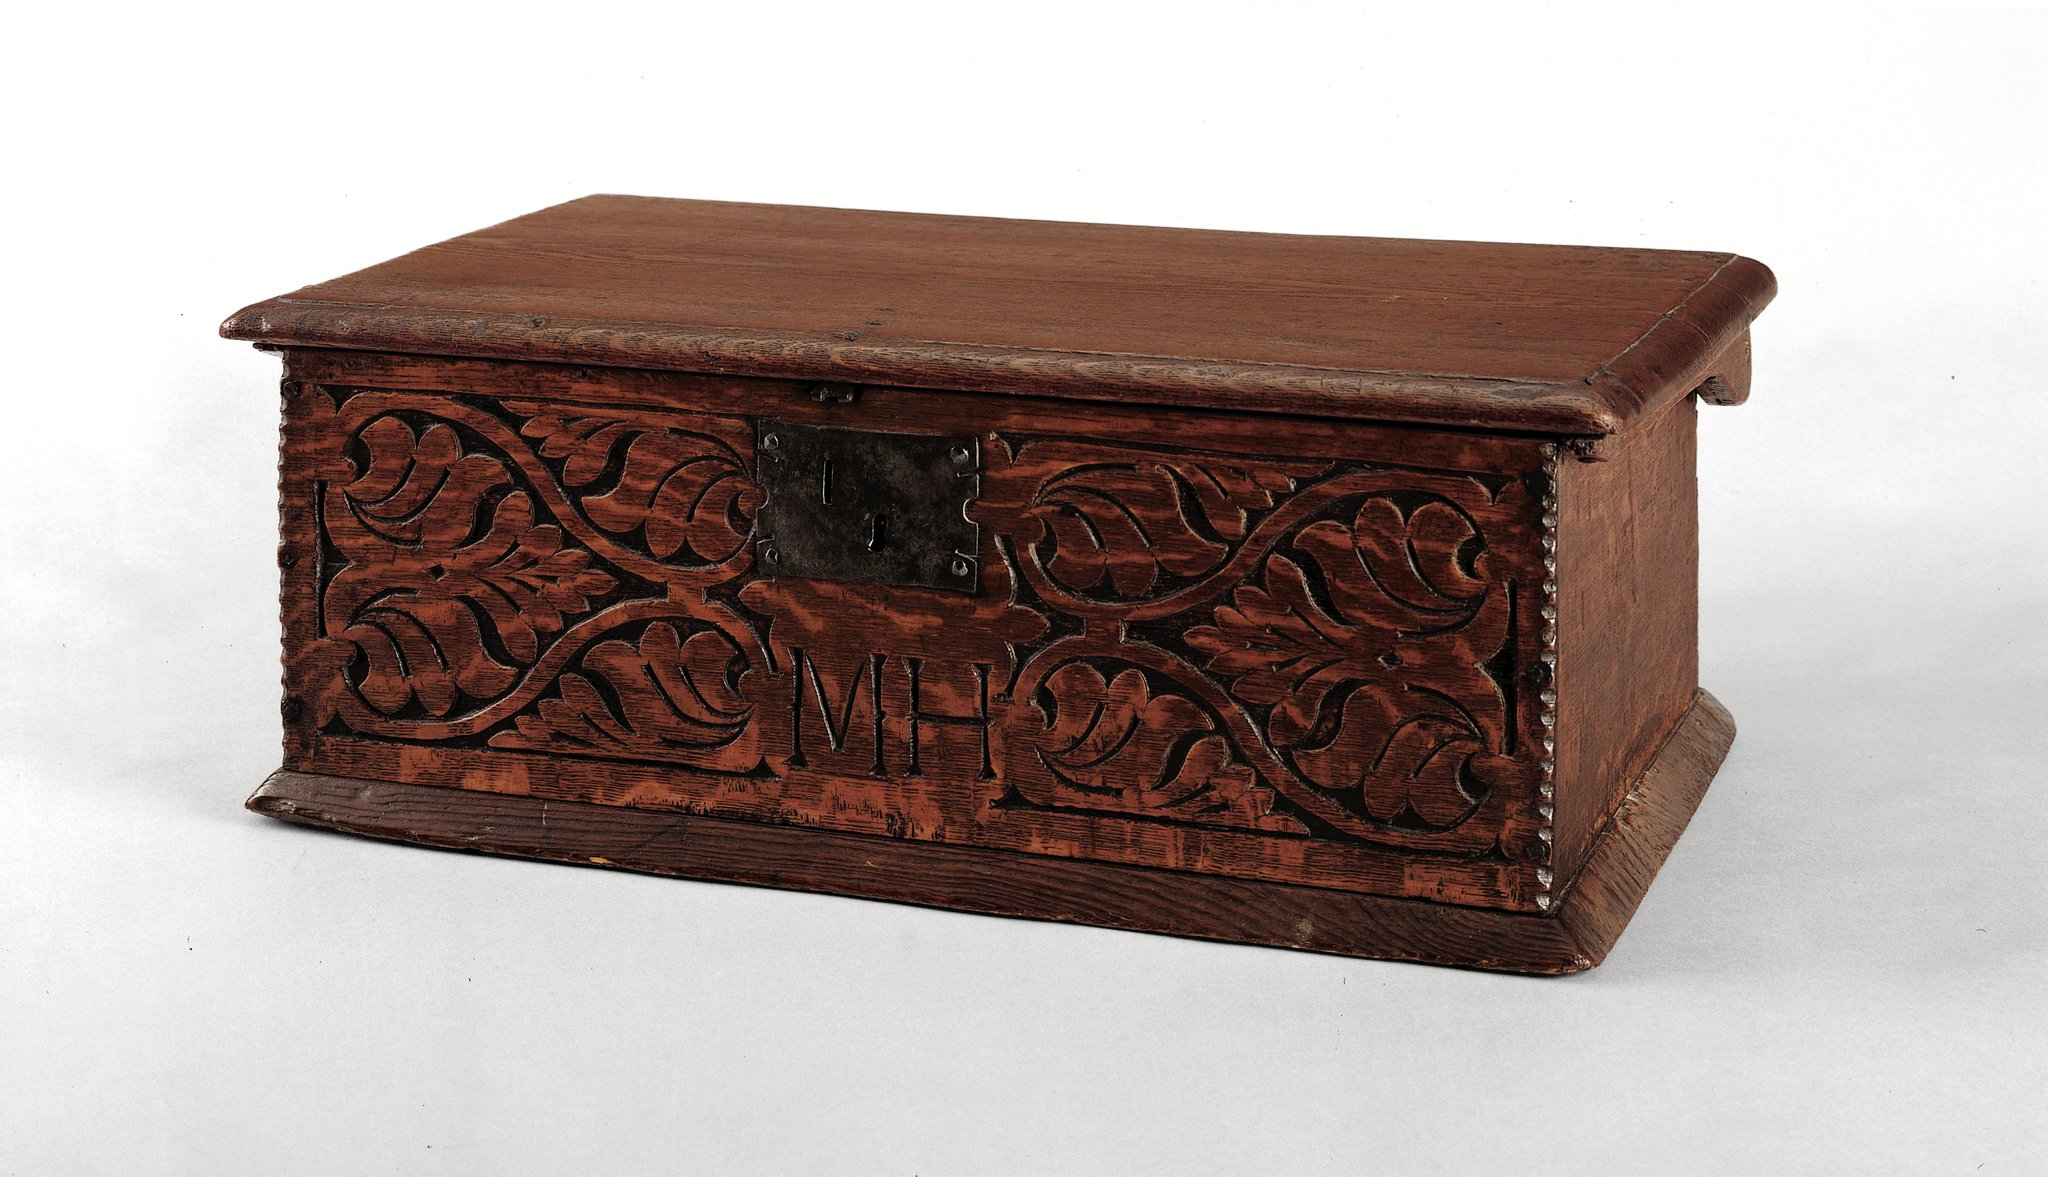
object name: box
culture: american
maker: john thurston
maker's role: maker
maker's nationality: american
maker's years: 1607-1685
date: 1660-1685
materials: wood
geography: united states